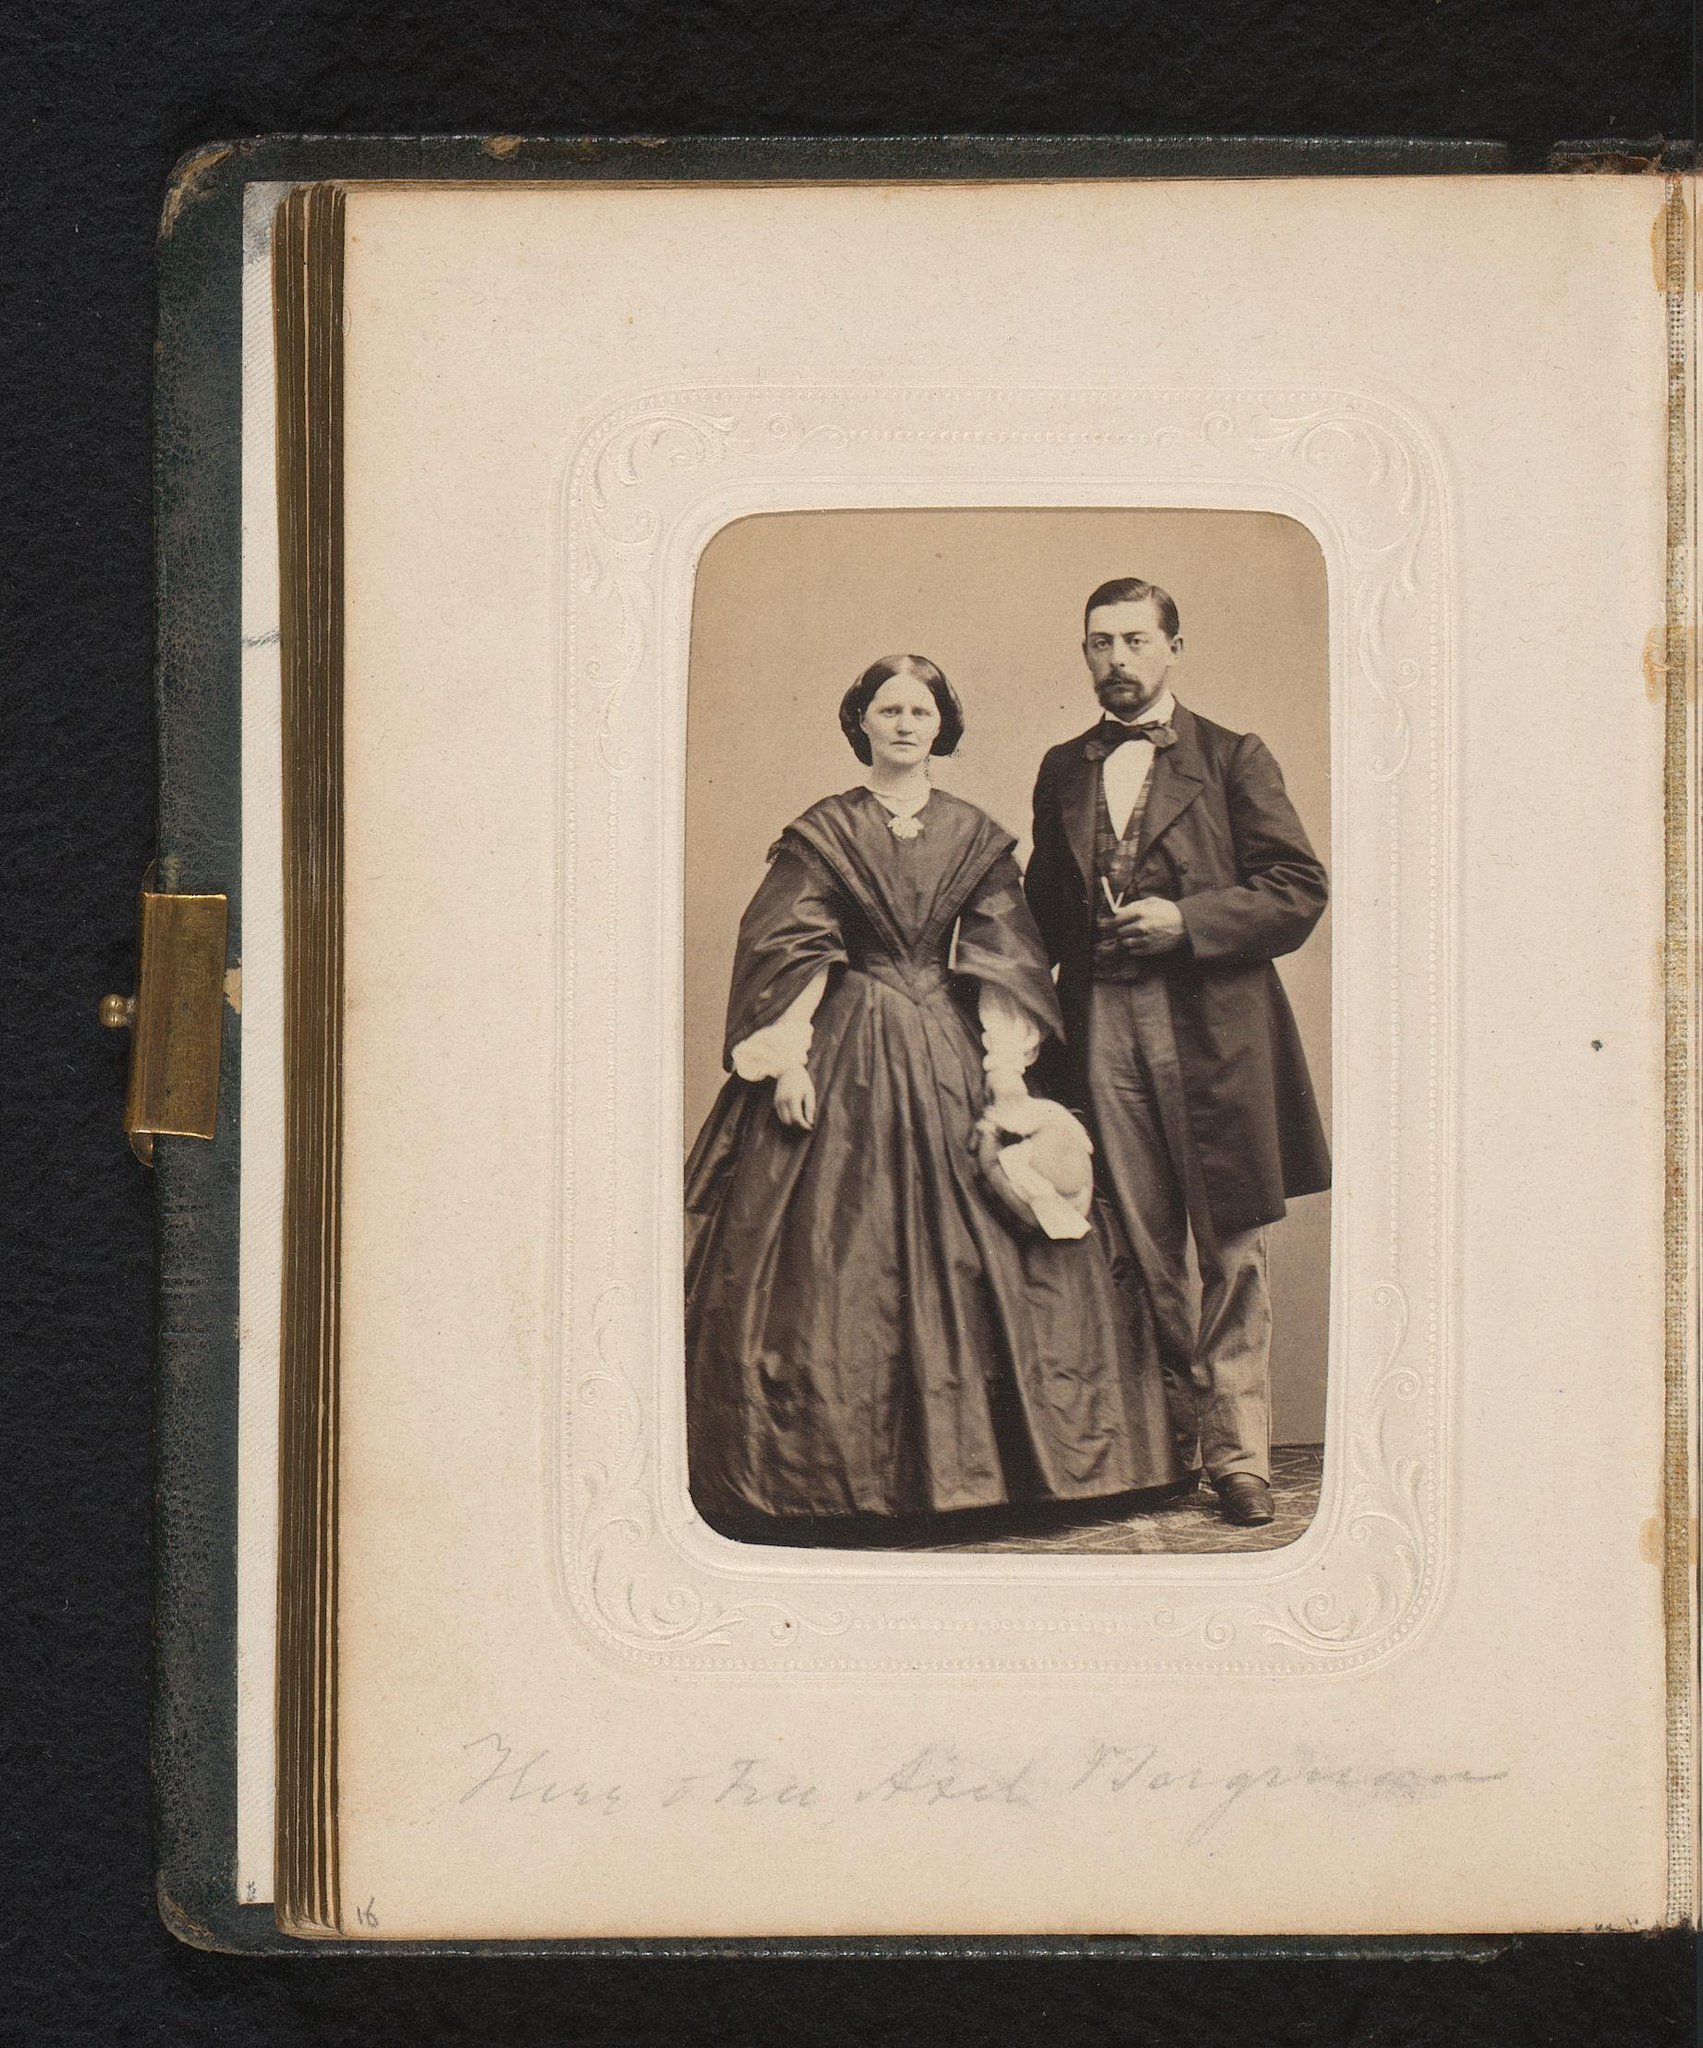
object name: album leaf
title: Portret van een man en een vrouw, aangeduid als de heer en mevrouw A.O. Bergman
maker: Anonymous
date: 1860-1900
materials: cardboard, photographic support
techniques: albumen print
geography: sweden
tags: historical persons - bb - woman, historical persons, marriage, married couple, 'matrimonium'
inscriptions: name: ‘Herr & Fru A[...] Bergman’, annotation: ‘Fru och Herr/ A.O. Bergman’